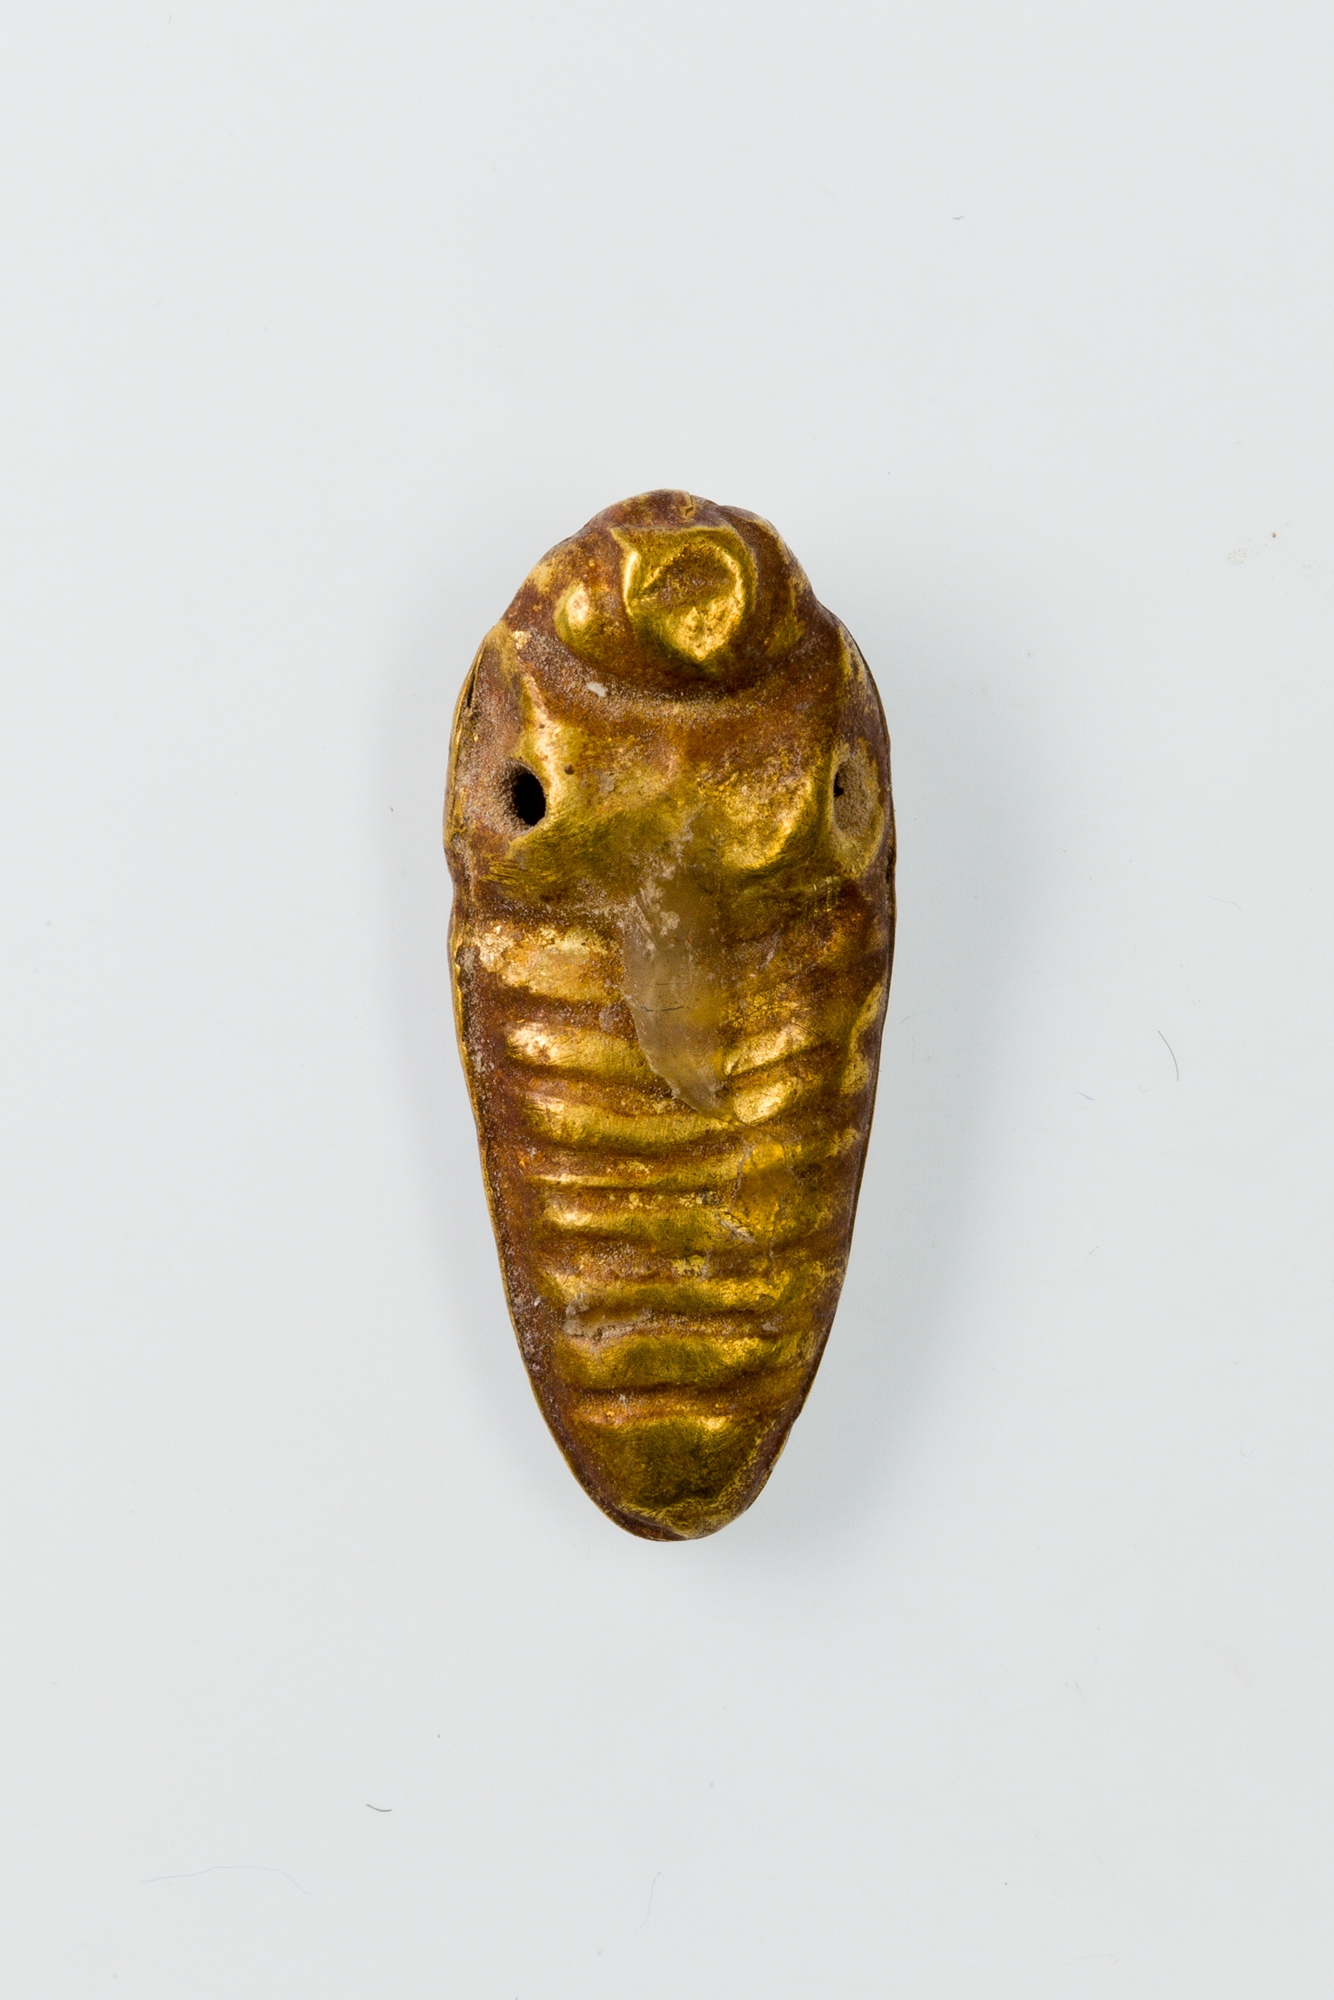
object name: necklace, bead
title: Amulet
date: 1950-1850 BCE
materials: gold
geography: egypt